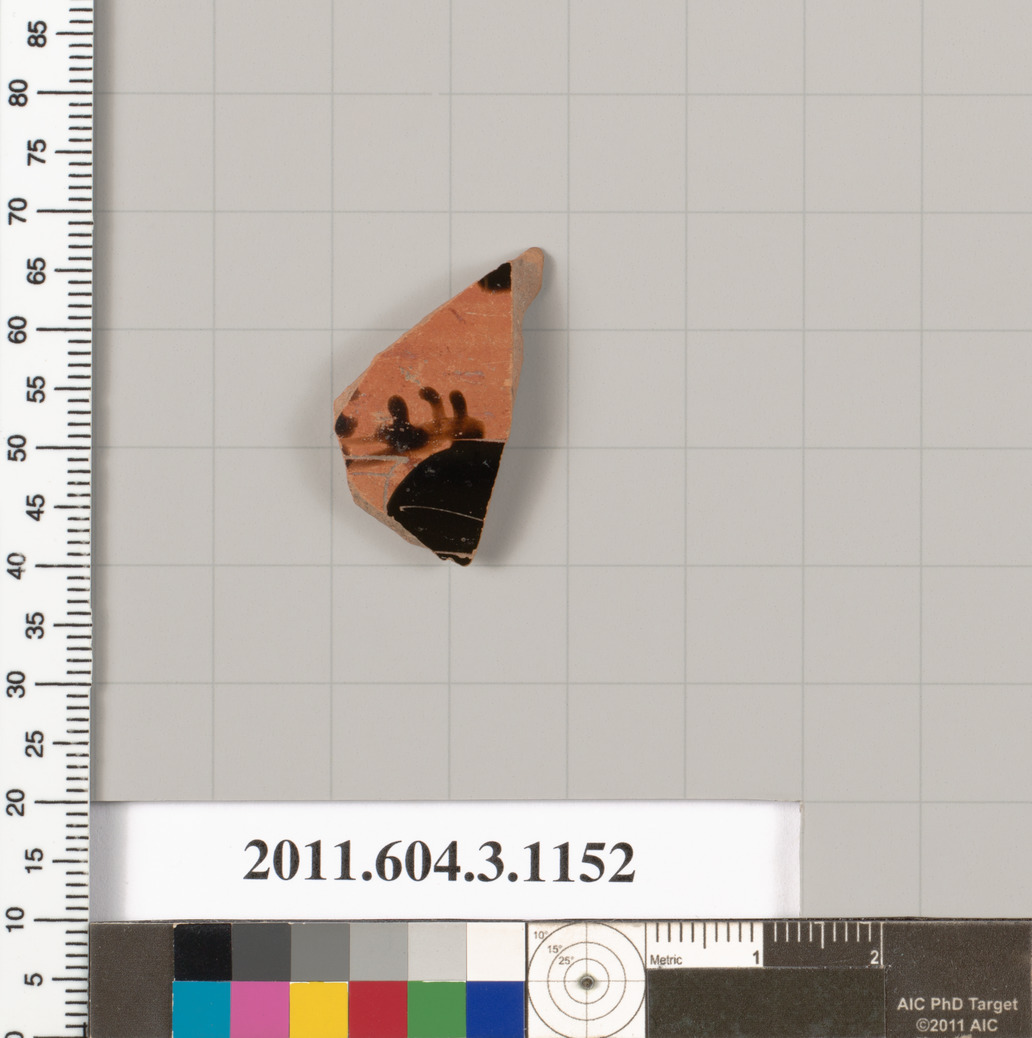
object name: mastoid or kyathos fragment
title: Terracotta fragment of a mastoid (drinking cup with narrow base) or a kyathos (cup-shaped ladle)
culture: greek, attic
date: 534-468 BCE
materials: terracotta